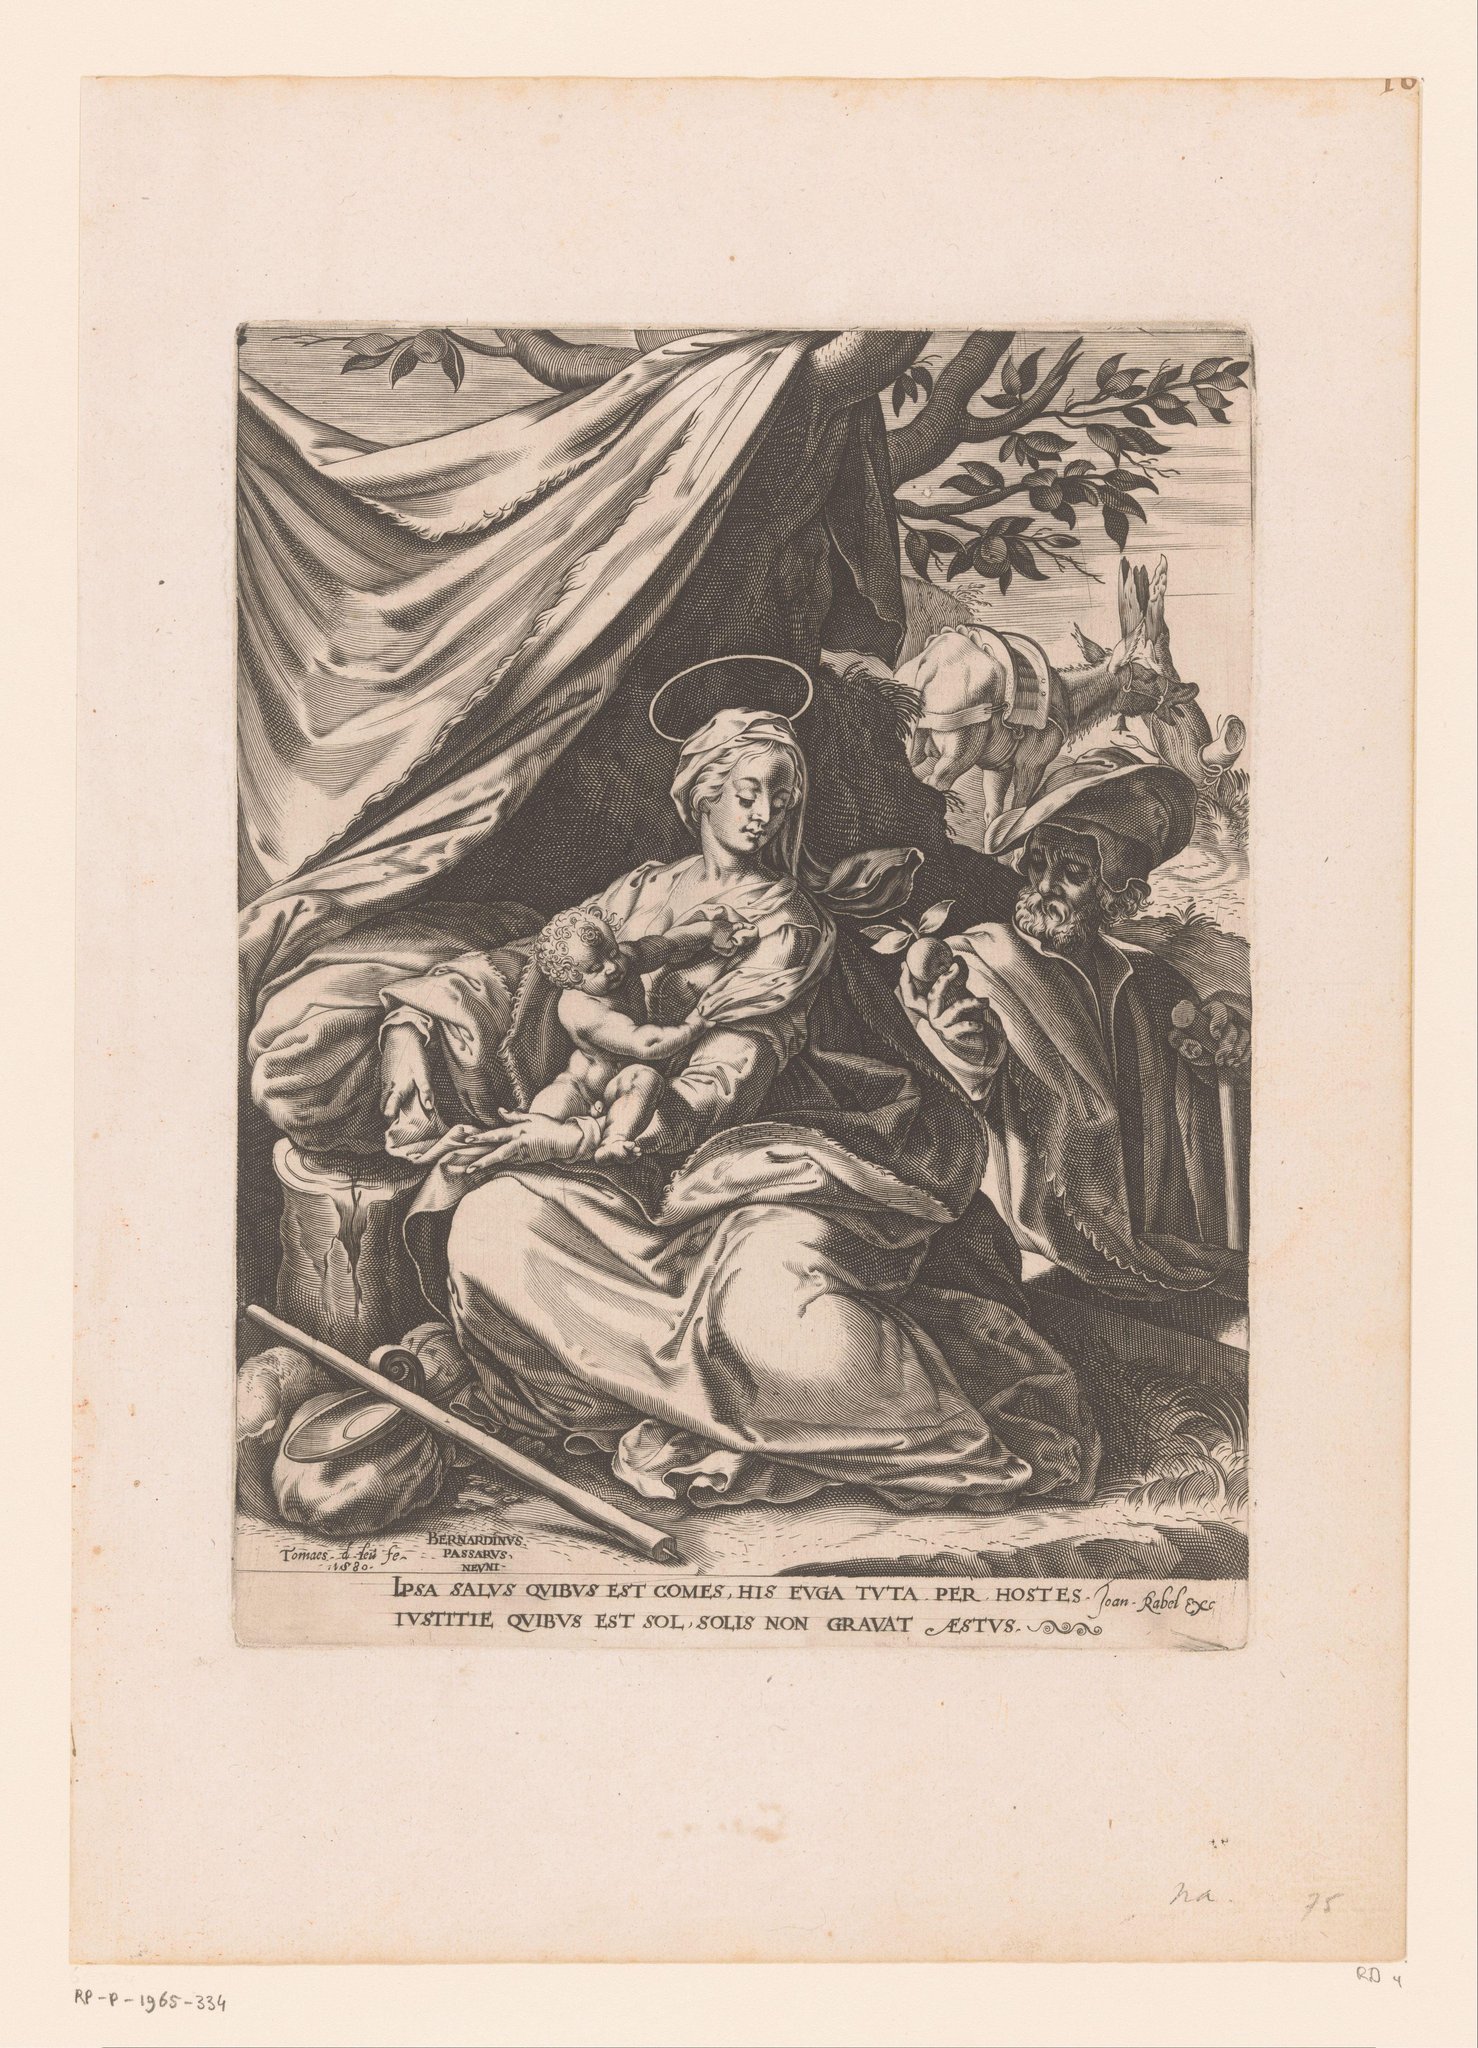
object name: print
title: Rest on the Flight into Egypt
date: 1580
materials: paper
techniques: engraving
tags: rest on the flight into egypt, journey of mary and joseph to bethlehem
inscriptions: collector's mark: Lugt 2228, collector's mark: Lugt 2760